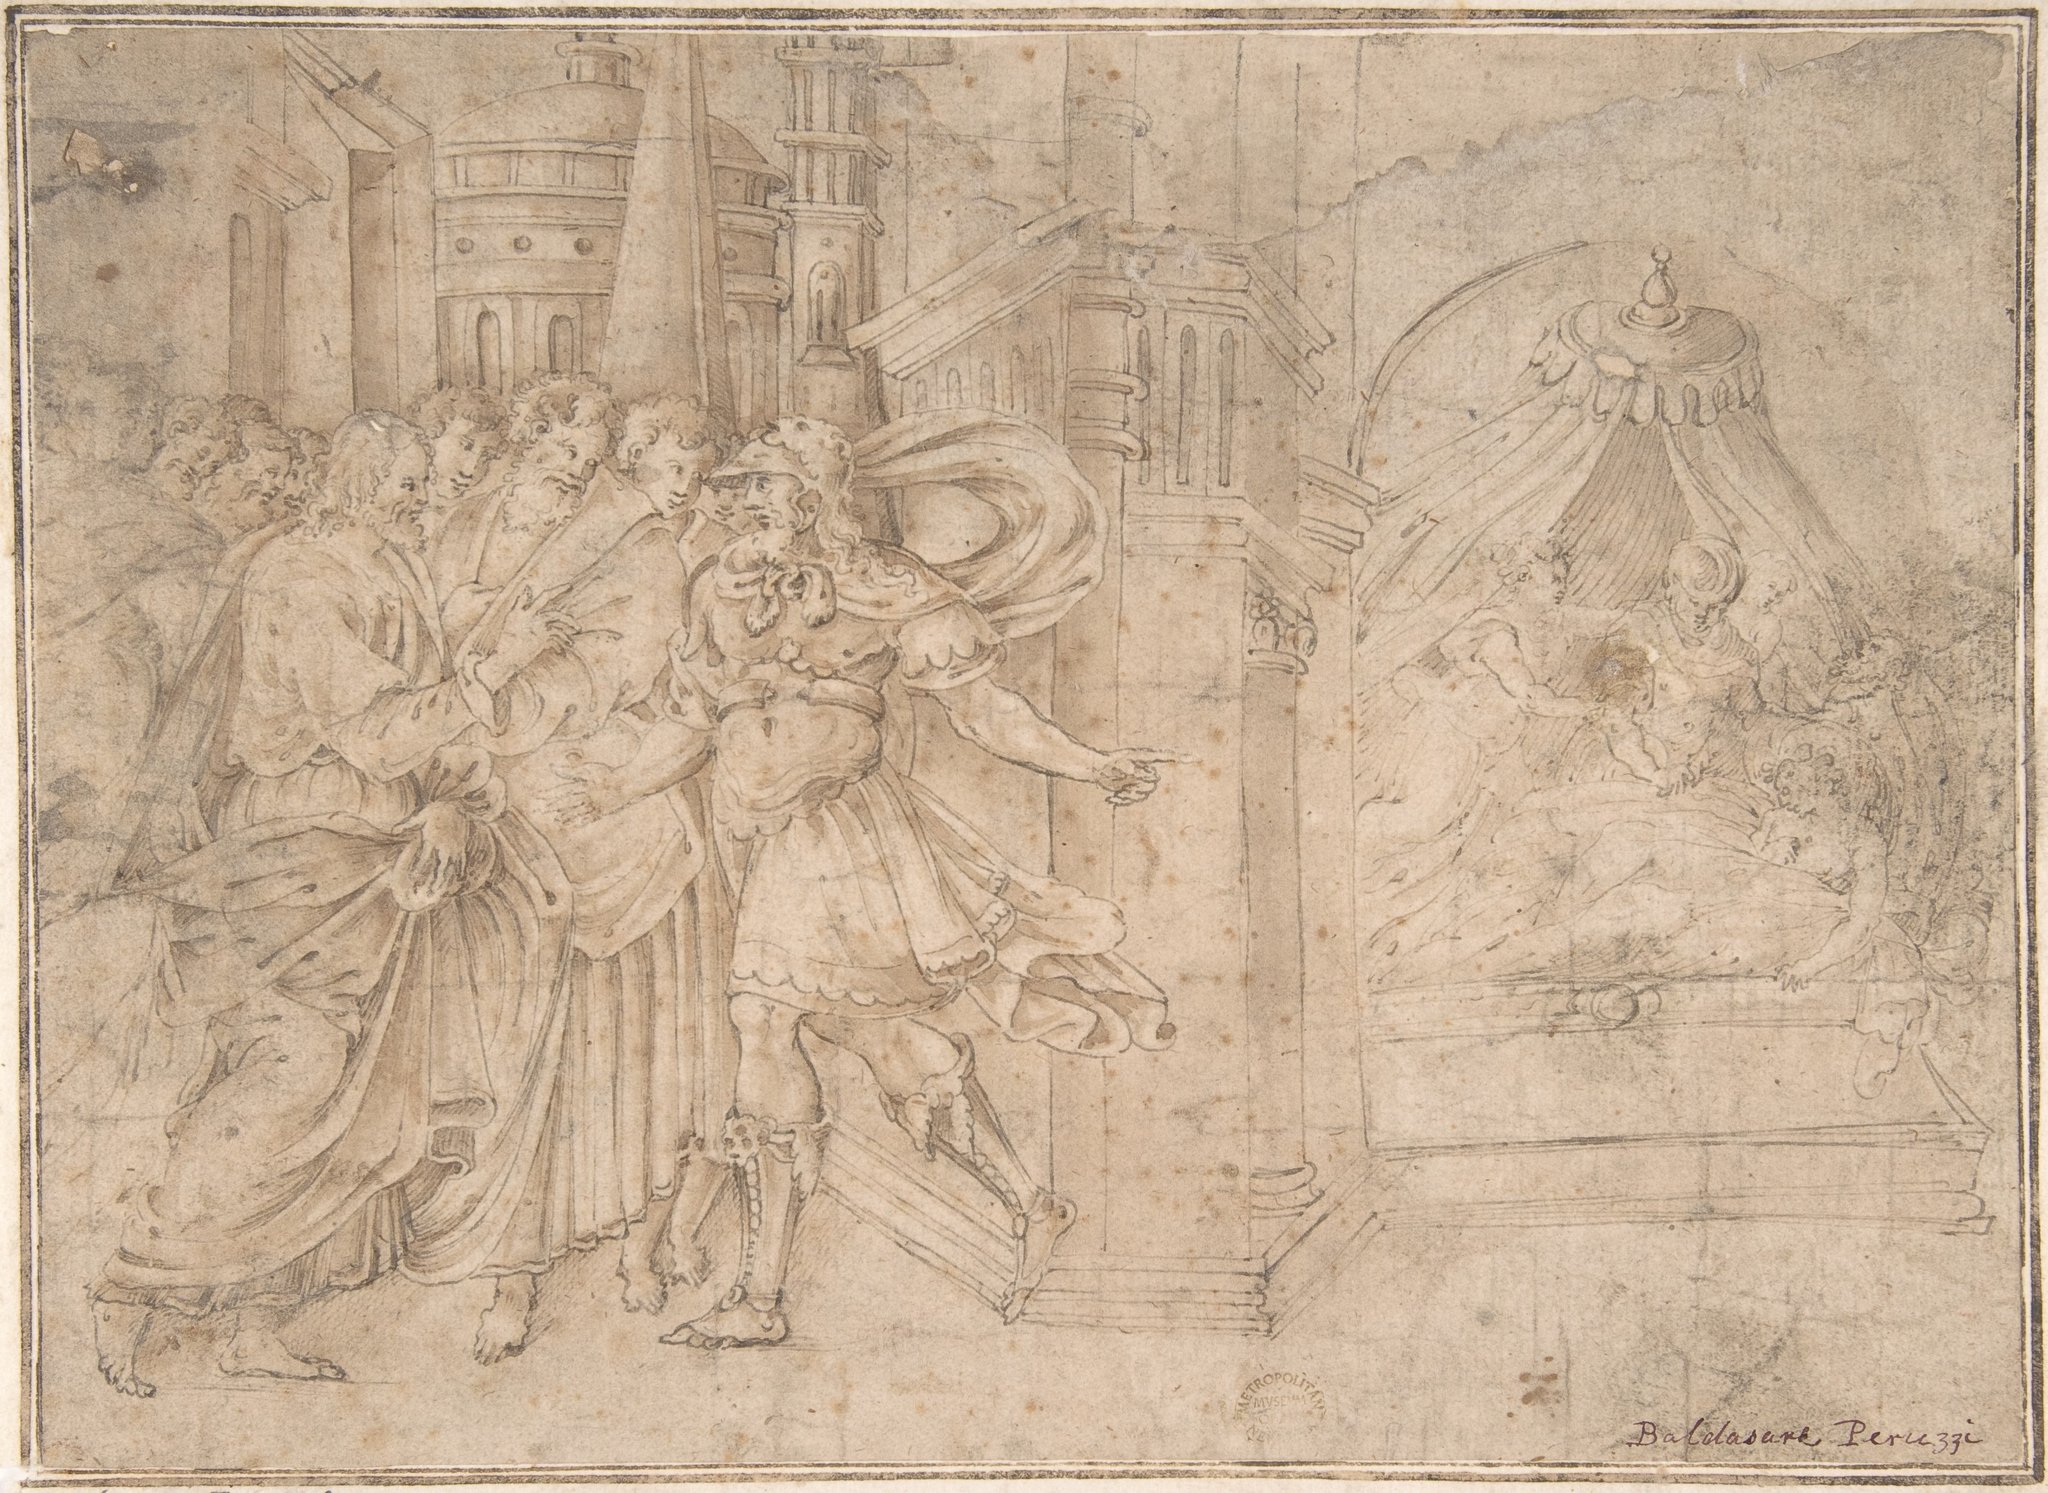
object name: drawing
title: Christ and the Daughter of the Centurion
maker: perino del vaga (pietro buonaccorsi)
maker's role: artist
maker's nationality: italian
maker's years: 1501-1547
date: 1501-1600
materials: chalk, ink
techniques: brush, pen, wash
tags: men,women,christ